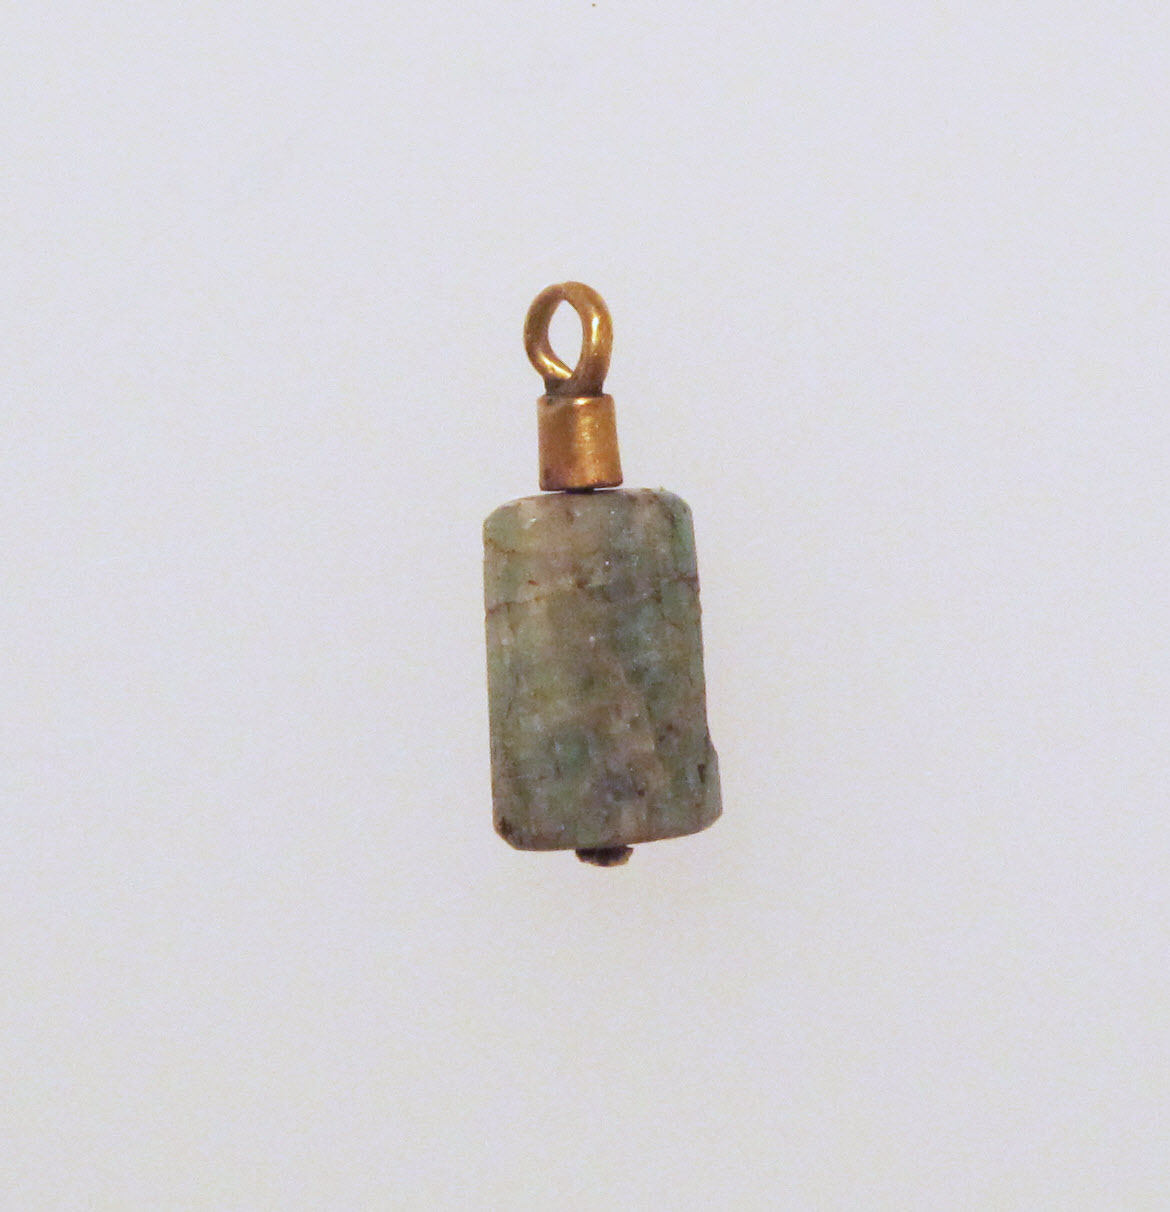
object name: pendant with sard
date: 7000 BCE-330 CE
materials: gold